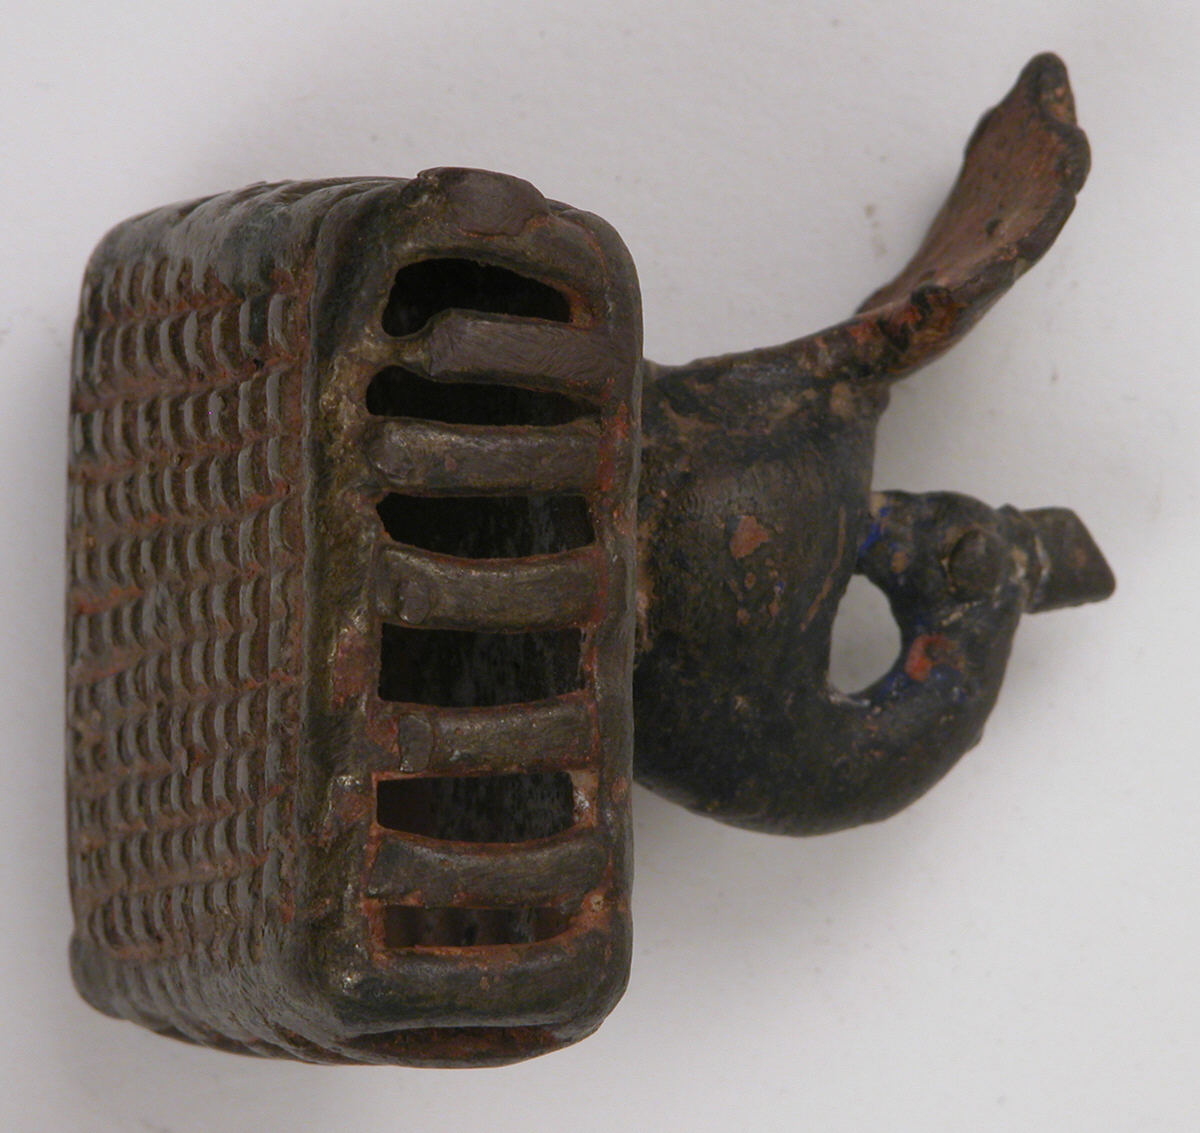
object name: figure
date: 1801-1900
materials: brass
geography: india